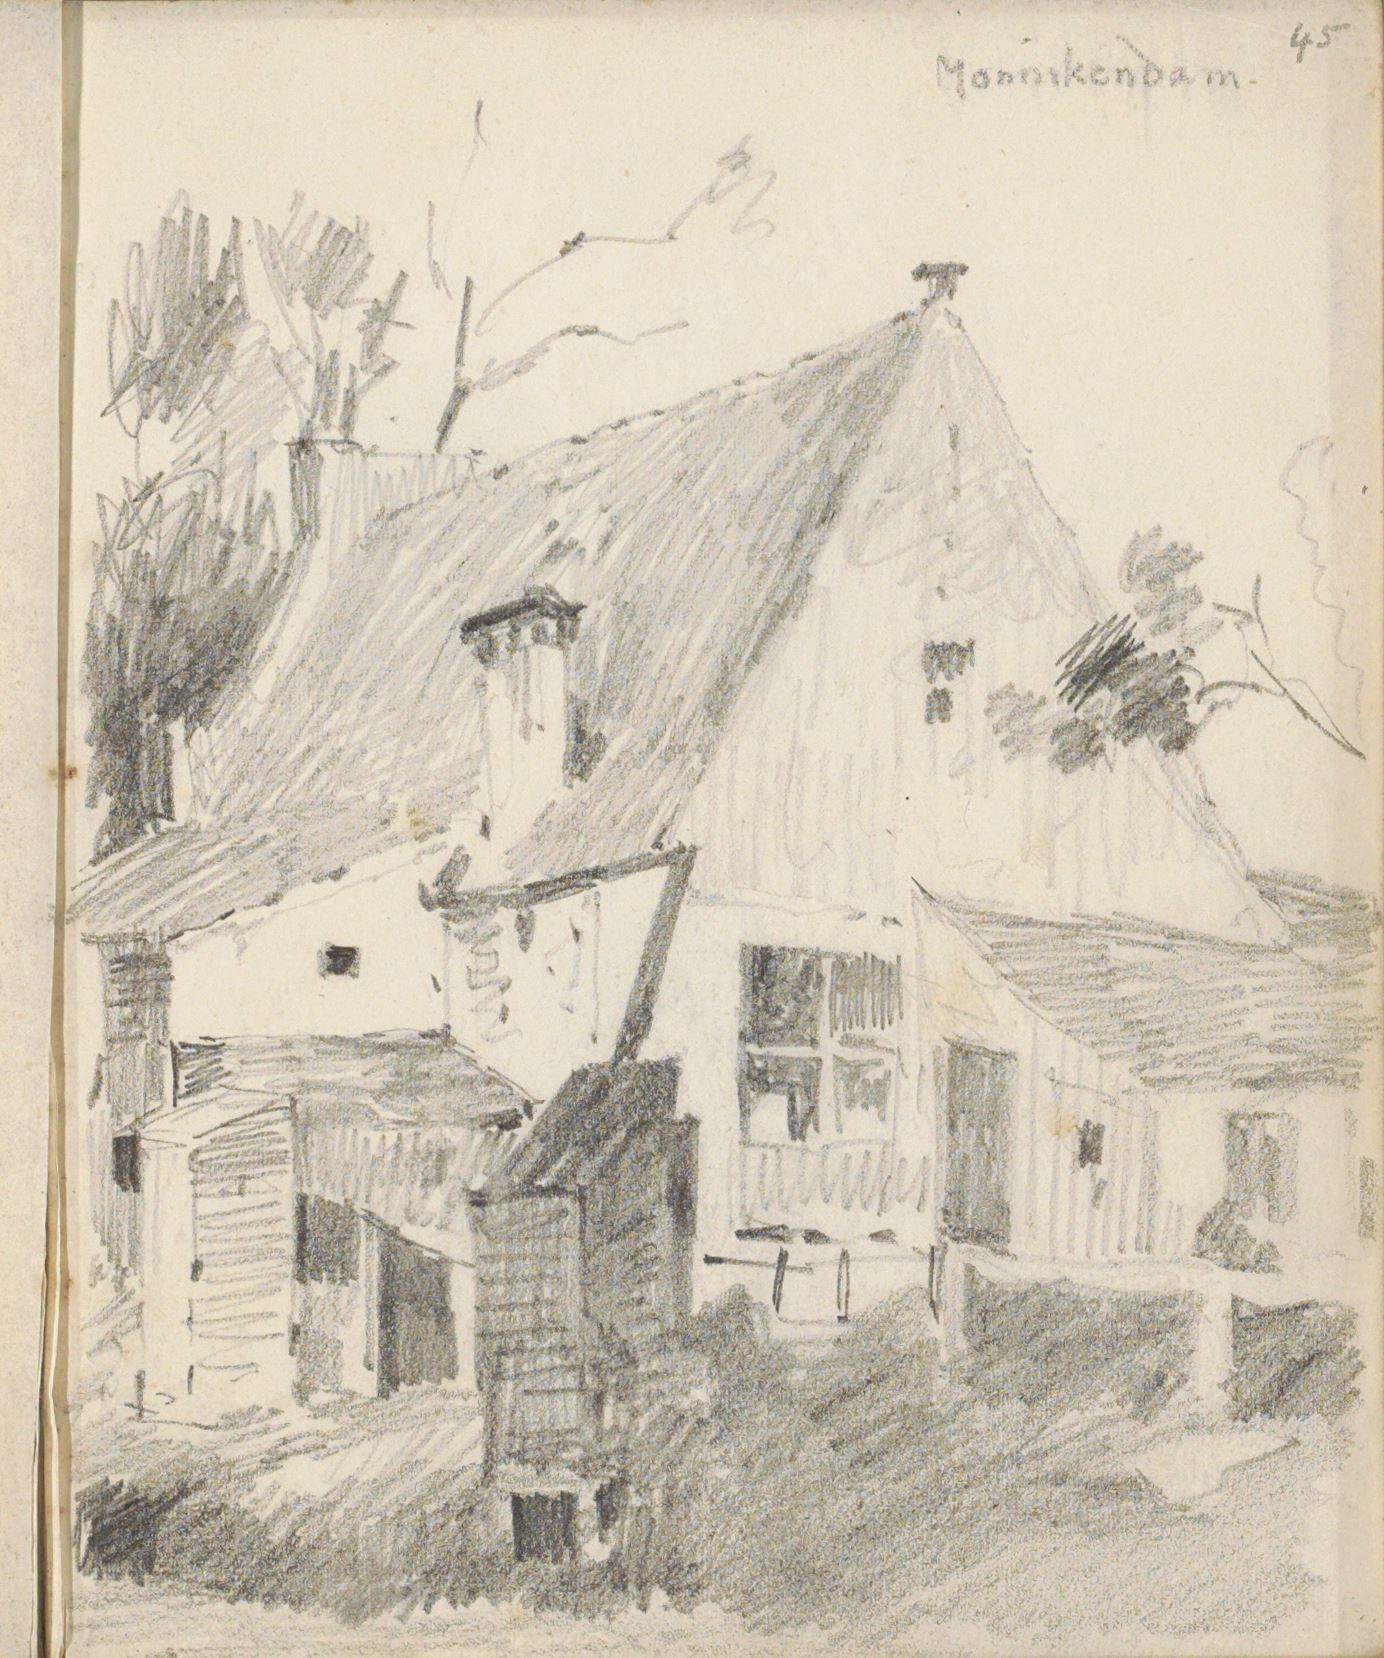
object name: sketchbook leaf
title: Huis te Monnickendam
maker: alfred william rich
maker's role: draughtsman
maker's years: 1856-1921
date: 1892-1893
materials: paper, pencil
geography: monnickendam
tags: the usual house or row of houses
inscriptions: annotation: ‘Monnikendam’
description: Blad 45 recto uit een schetsboek met 86 bladen.